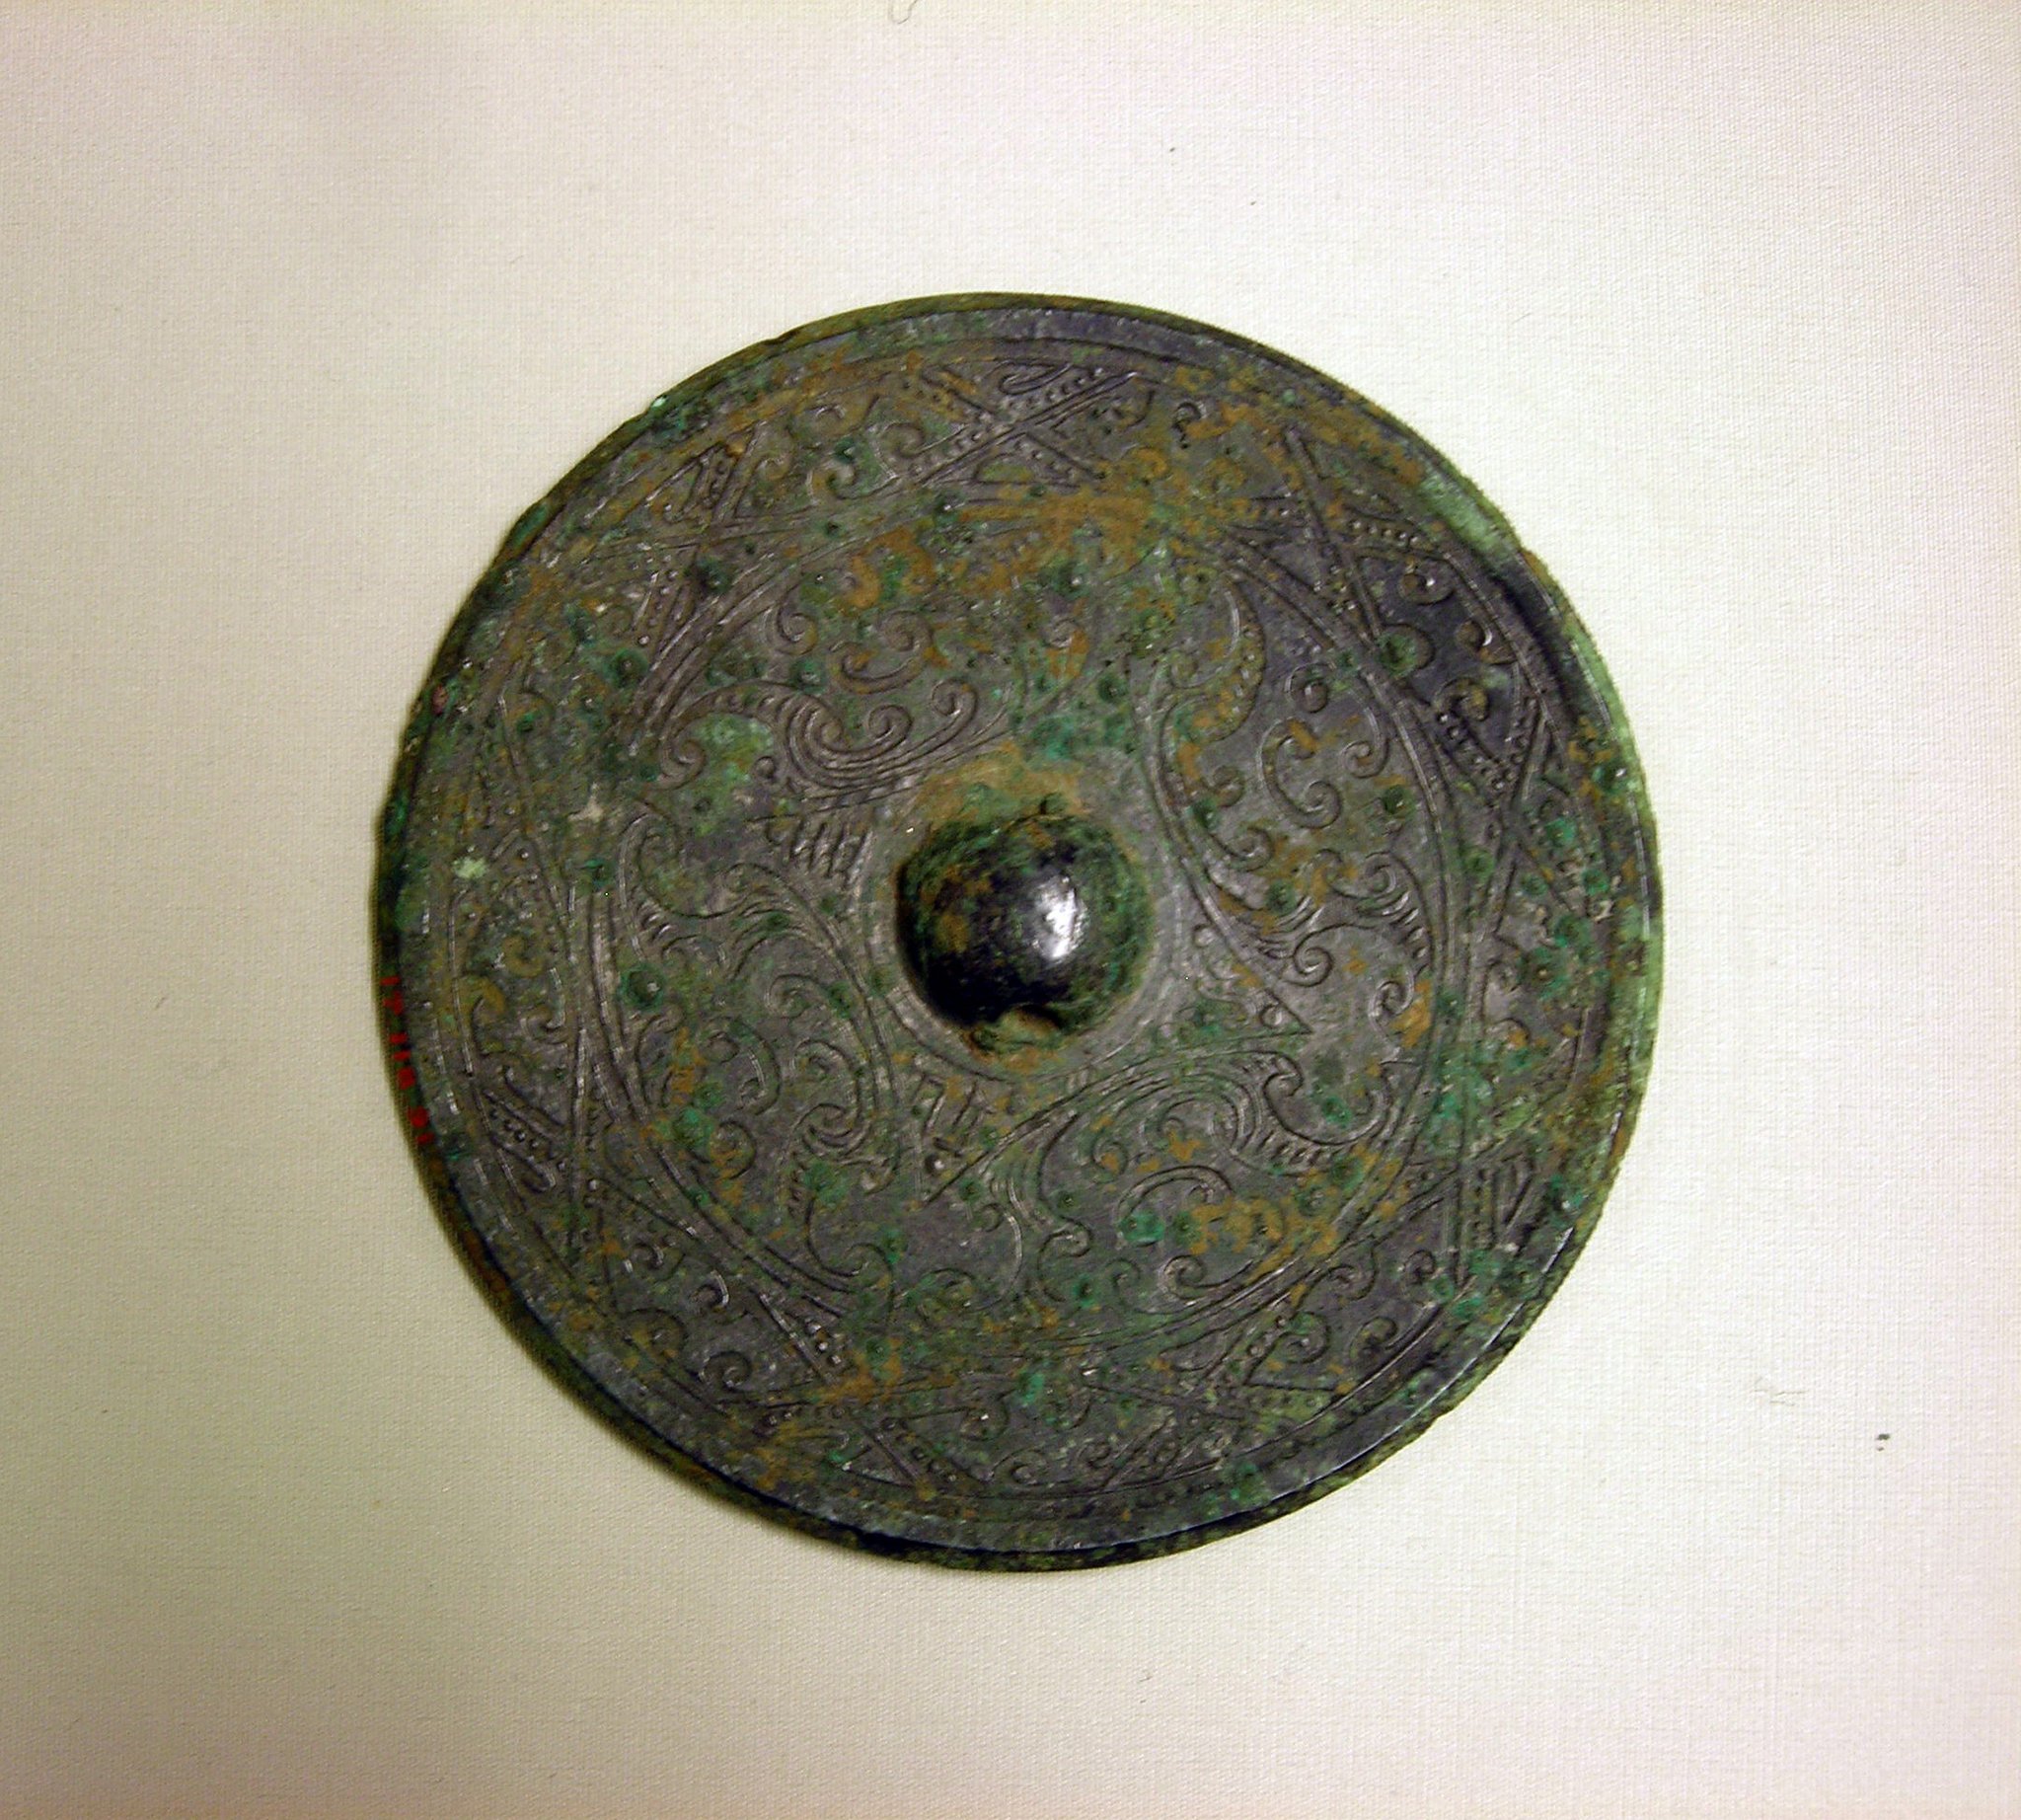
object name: mirror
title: Mirror with quatrefoil design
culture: chinese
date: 101-200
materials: bronze